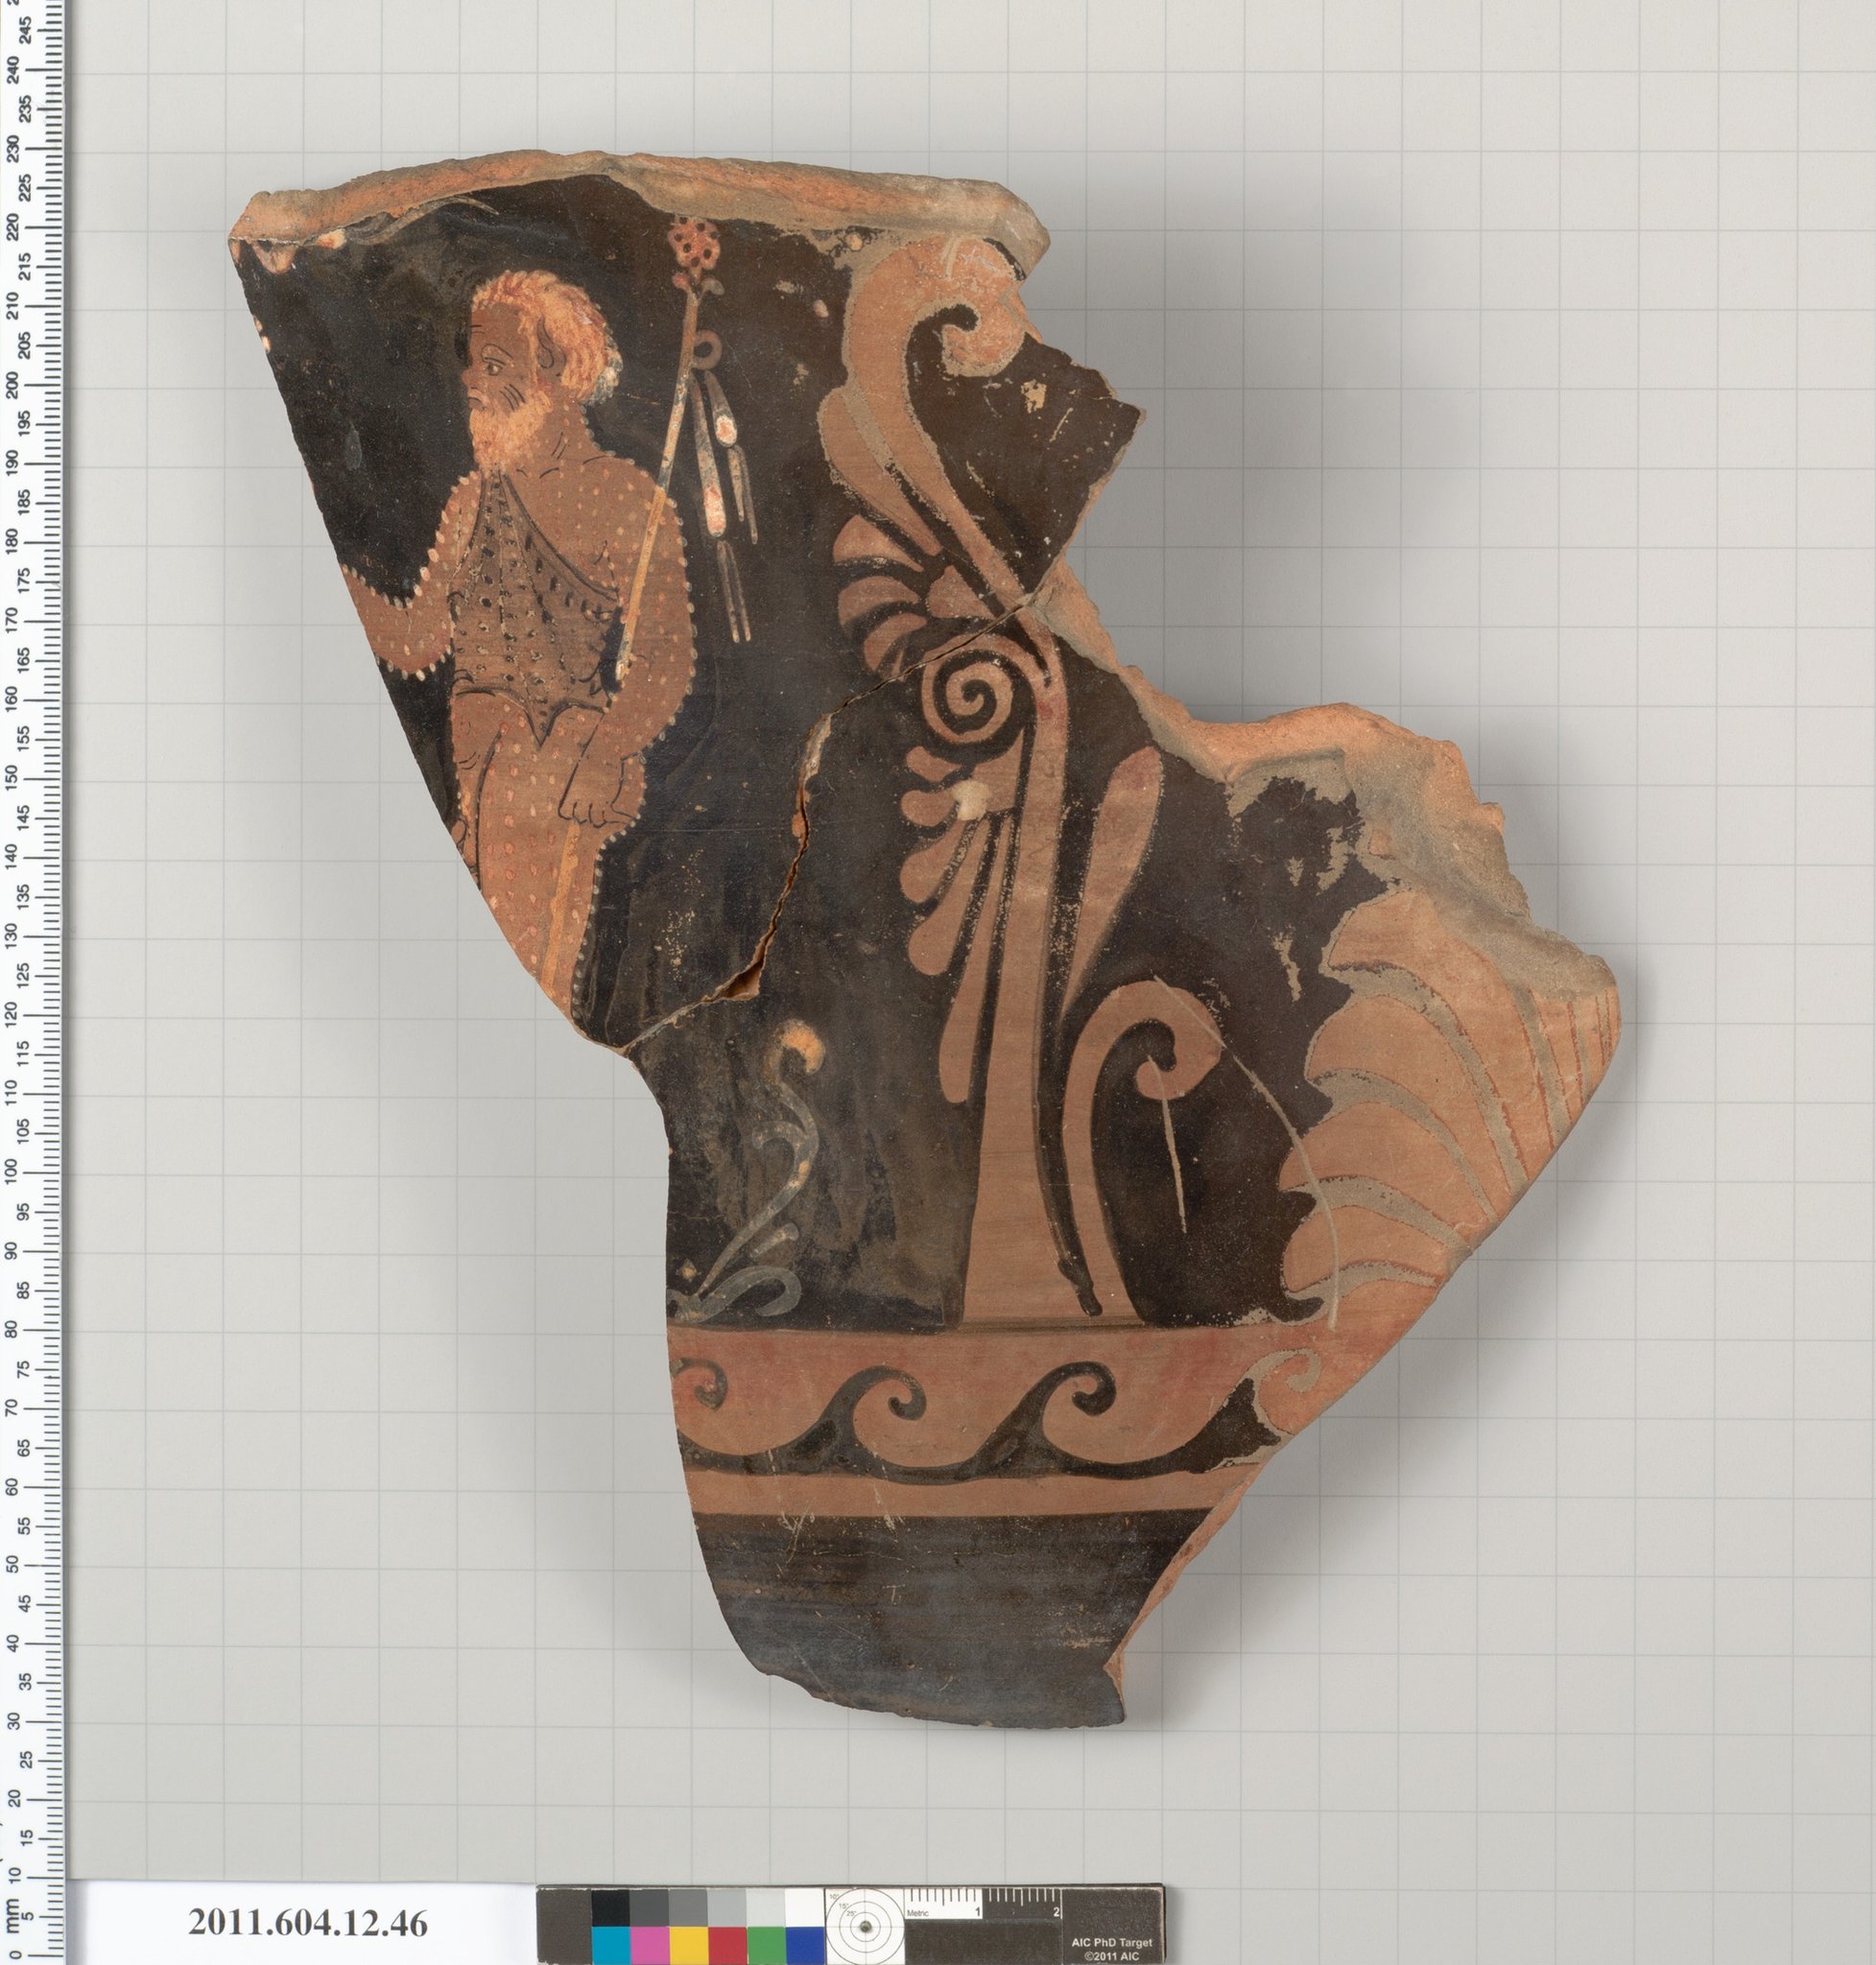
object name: bell krater fragment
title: Terracotta fragment of a bell-krater (deep bowl)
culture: greek, paestan or south italian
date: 350-326 BCE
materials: terracotta